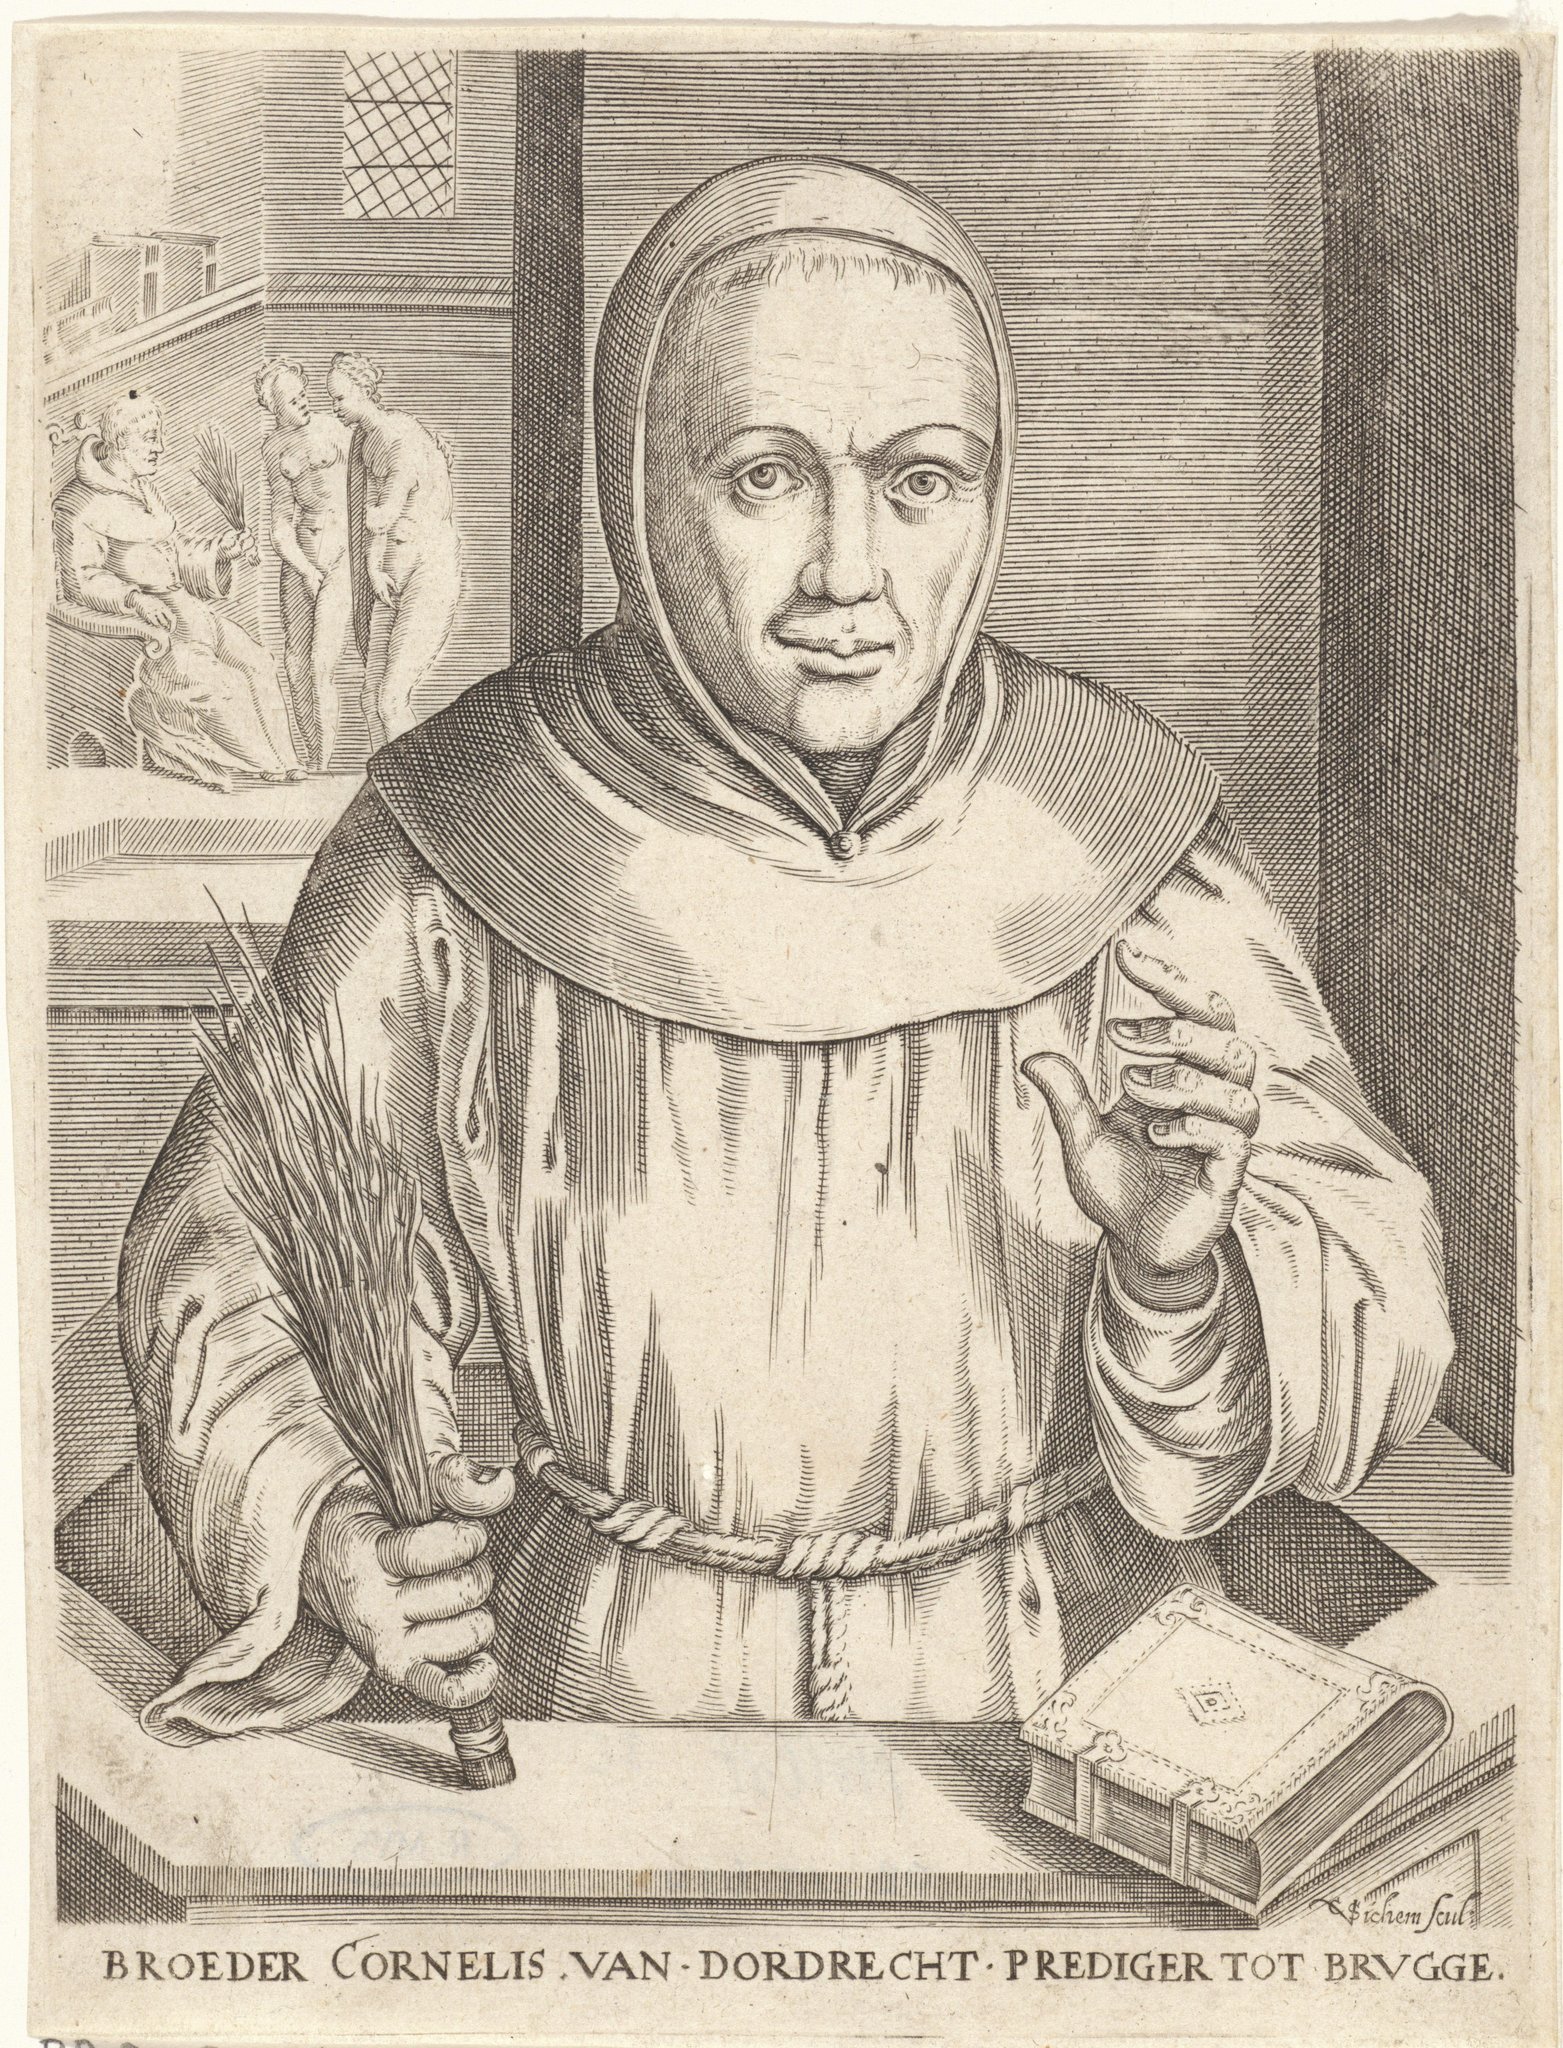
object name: print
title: Portret van Broer Cornelis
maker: christoffel van sichem (i)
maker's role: print maker, publisher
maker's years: 1546-1624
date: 1607-1677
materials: paper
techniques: engraving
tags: dordrecht, bruges, book with clasps, instruments of torture, execution or punishment: scourge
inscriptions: collector's mark: Lugt 2228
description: Prent komt voor in: C. van Sichem. Historische beschrĳvinge ende affbeeldinge der voorneemste hooft ketteren. Amsterdam: C. van Sichem, 1608., in: C. van Sichem. Historische Beschreibüng vnnd abbildünge der fürnembste Haubt-Ketzer. Amsterdam: C. Claesz, 1608. en in: C. van Sichem. Het tooneel der hooft-ketteren, bestaande in verscheyde afbeeltsels. Middelburg: W. Goeree, 1677.